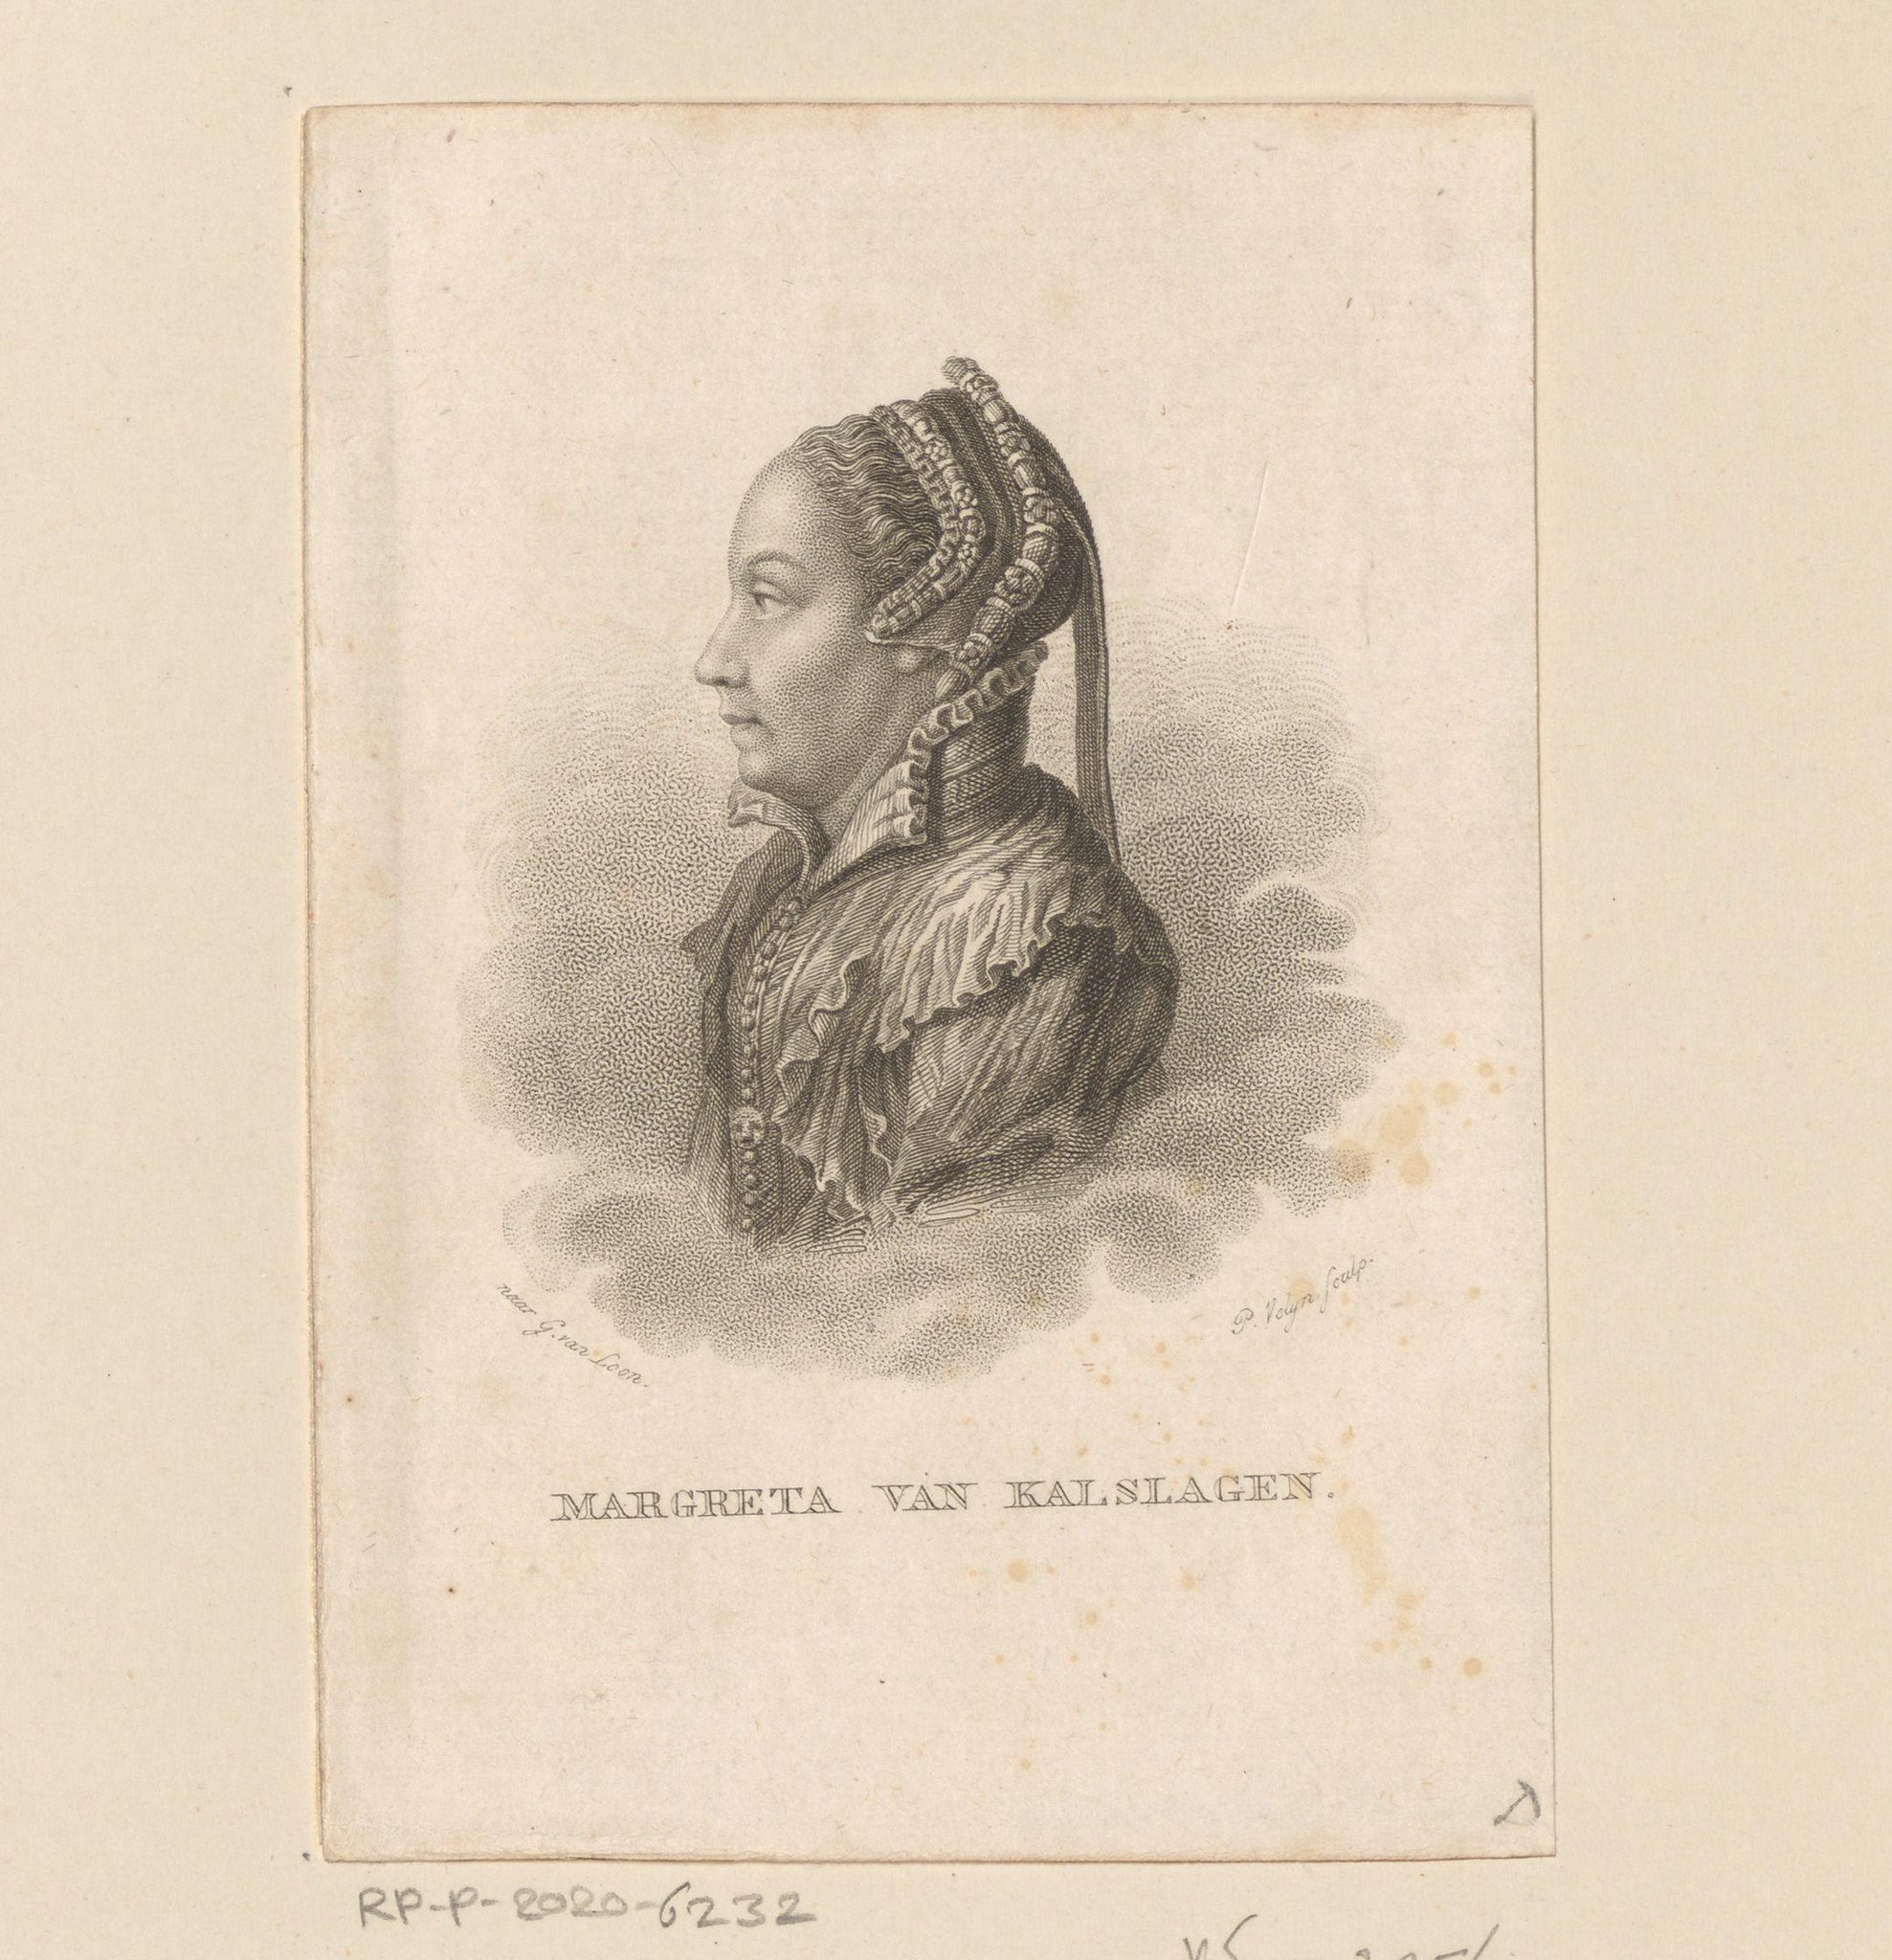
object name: print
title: Portret van Margaretha Coppier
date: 1797-1836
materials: paper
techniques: engraving, etching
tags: historical persons - bb - woman